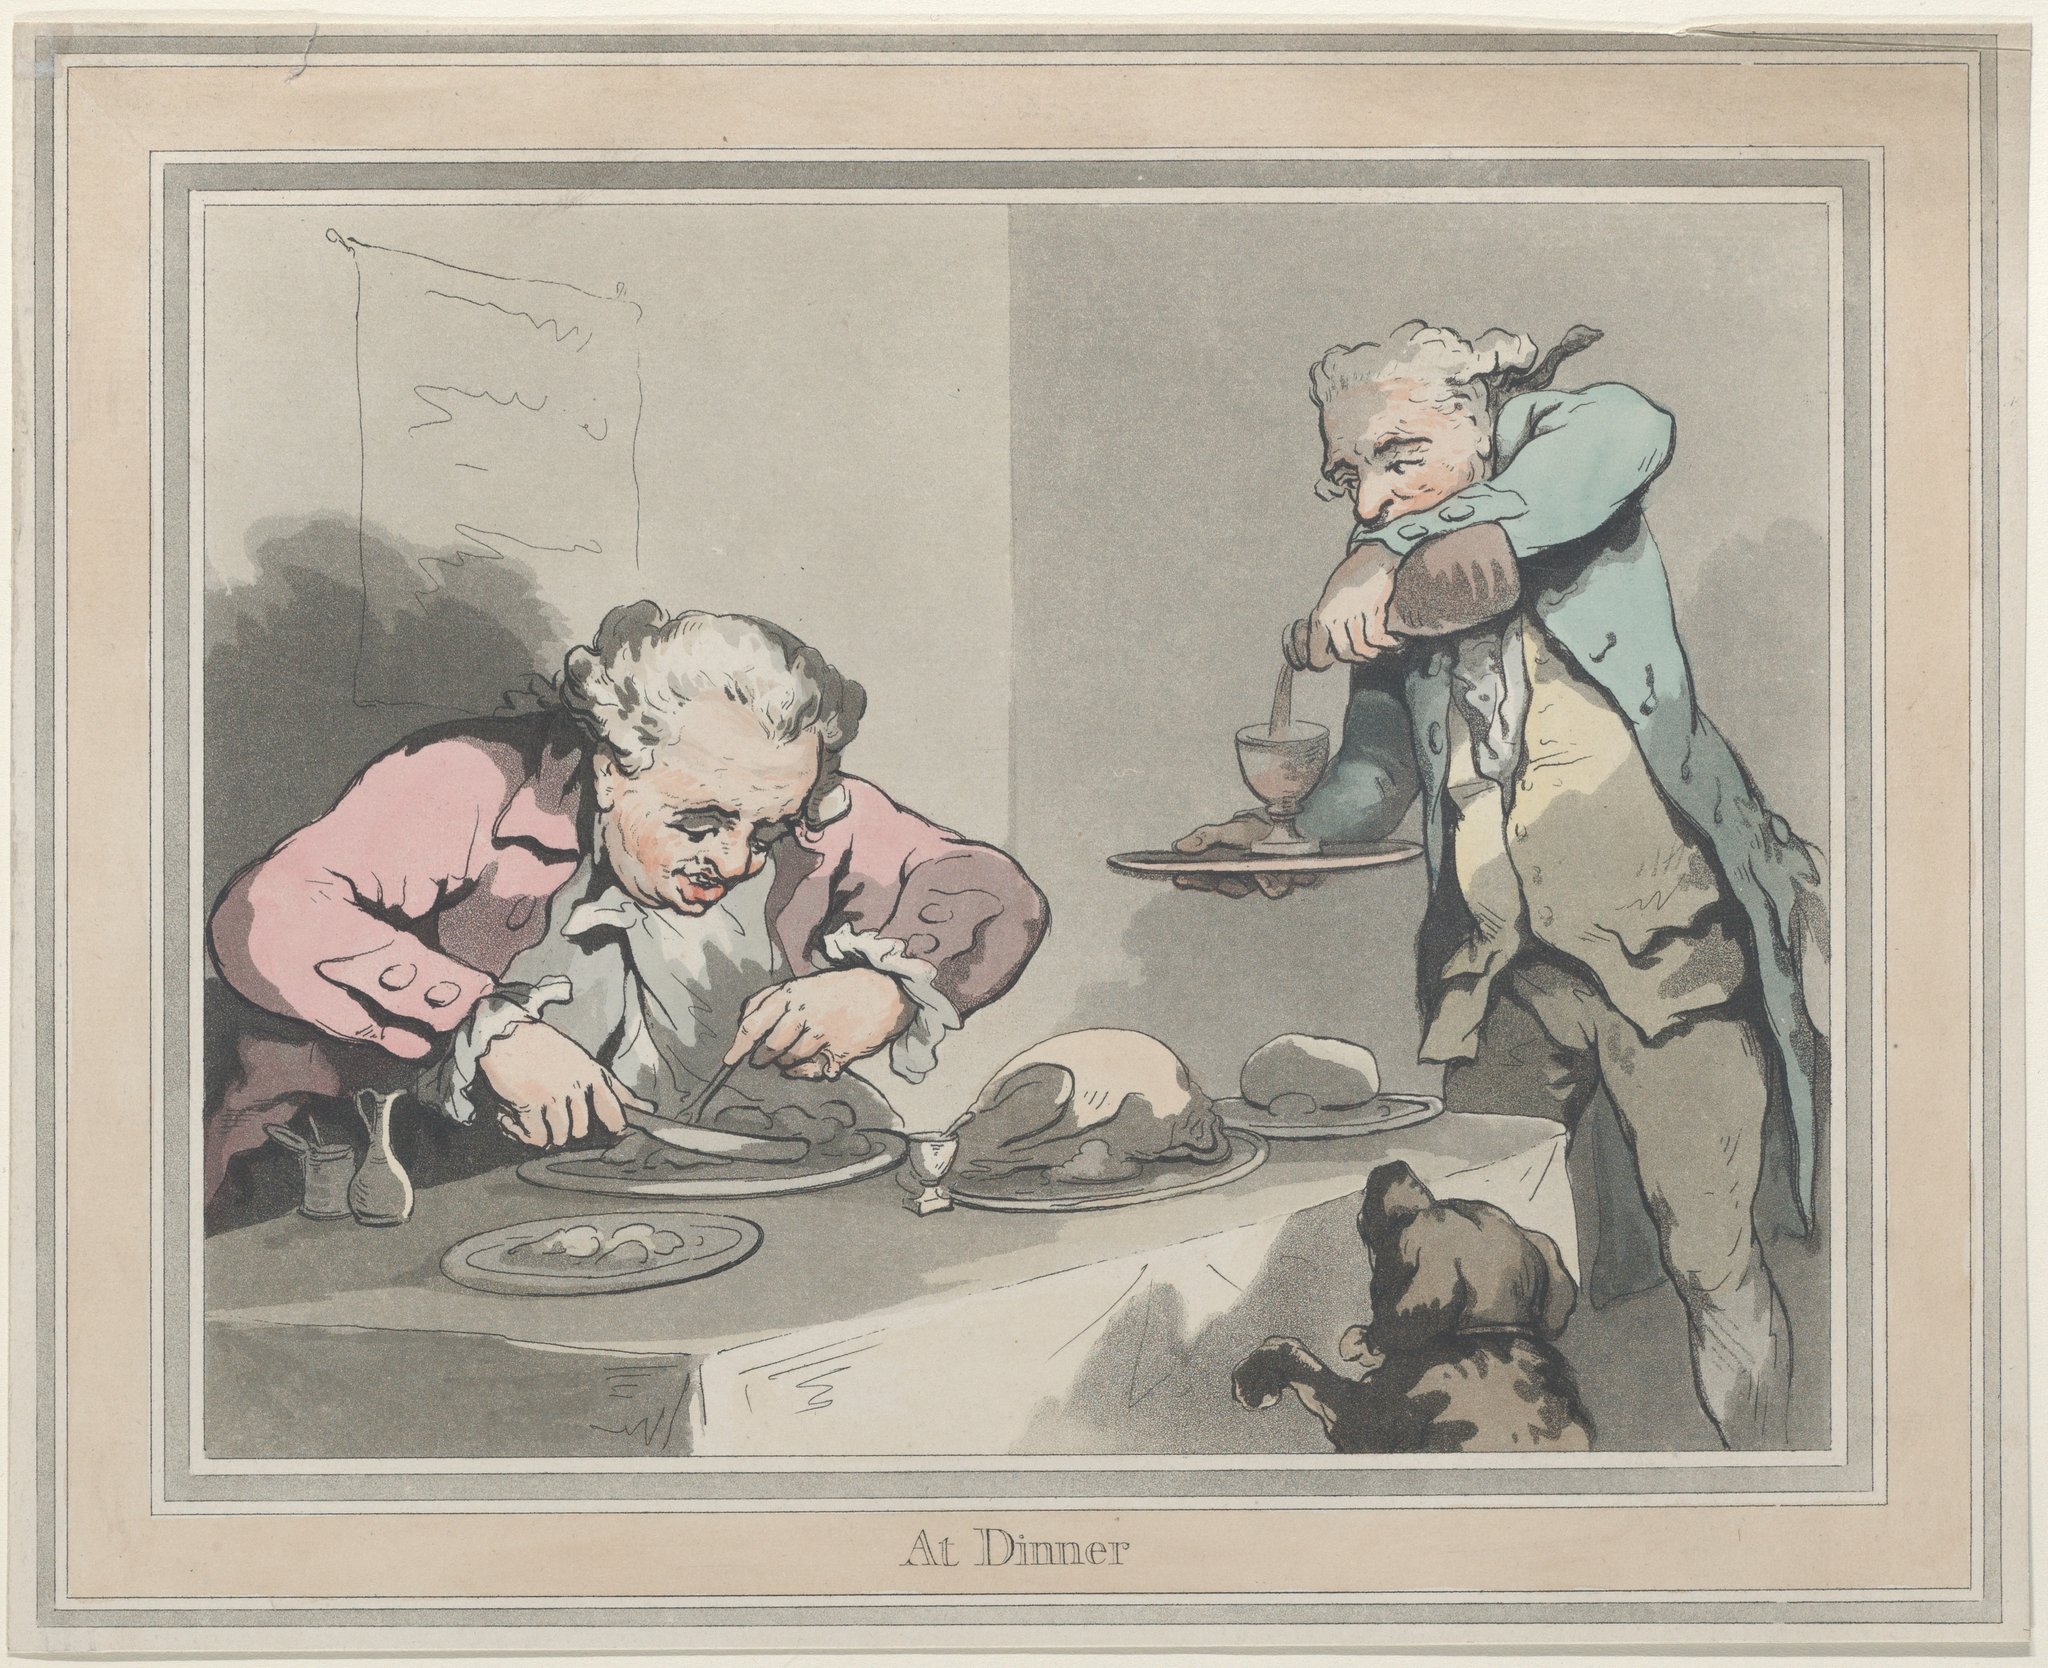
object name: print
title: At Dinner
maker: thomas rowlandson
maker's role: artist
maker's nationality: british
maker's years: 1757-1827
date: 1790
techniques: aquatint, etching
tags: food,satire,men,dogs,dining